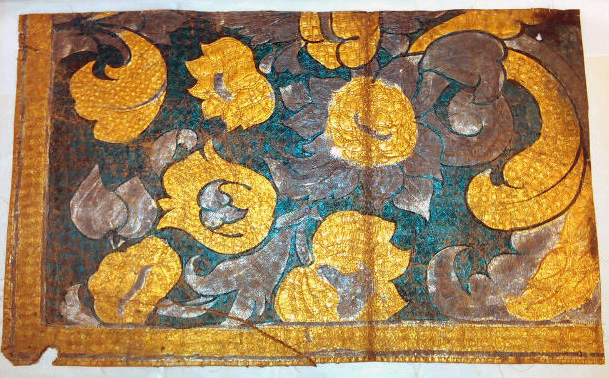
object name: embossed leather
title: Piece of Embossed Leather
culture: japanese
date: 1801-1900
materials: leather